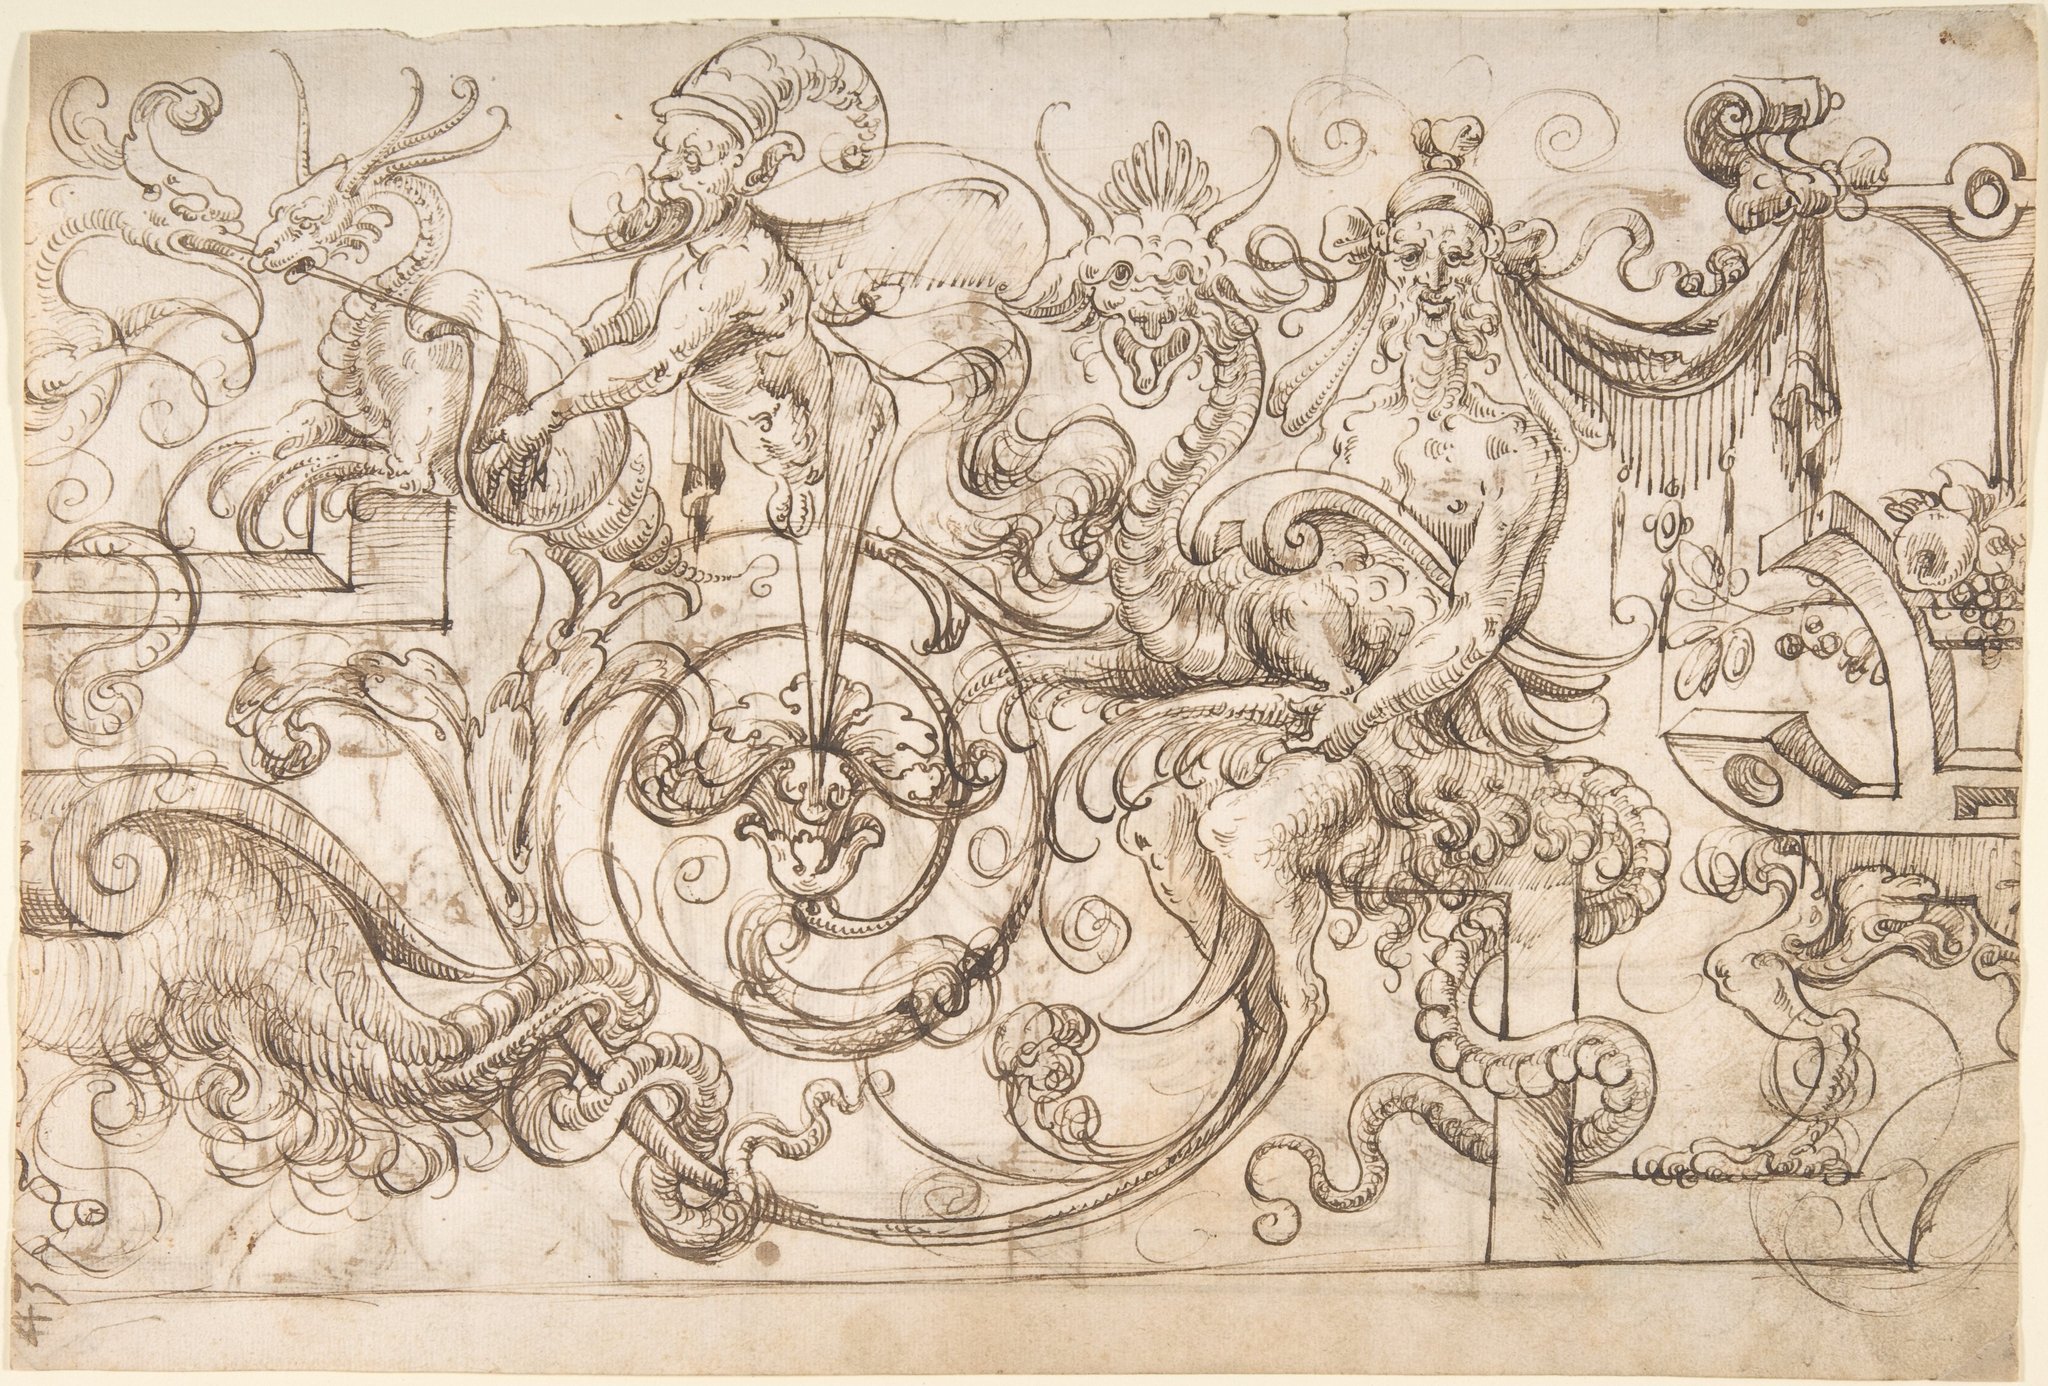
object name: drawing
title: Grotesque panel with satyrs, herms, and strapwork (recto); winged creatures and strapwork (verso)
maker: andrés de melgar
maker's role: artist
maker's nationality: spanish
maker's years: 1554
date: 1545-1560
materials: ink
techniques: pen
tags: birds,grotesques,ornament,mythical creatures